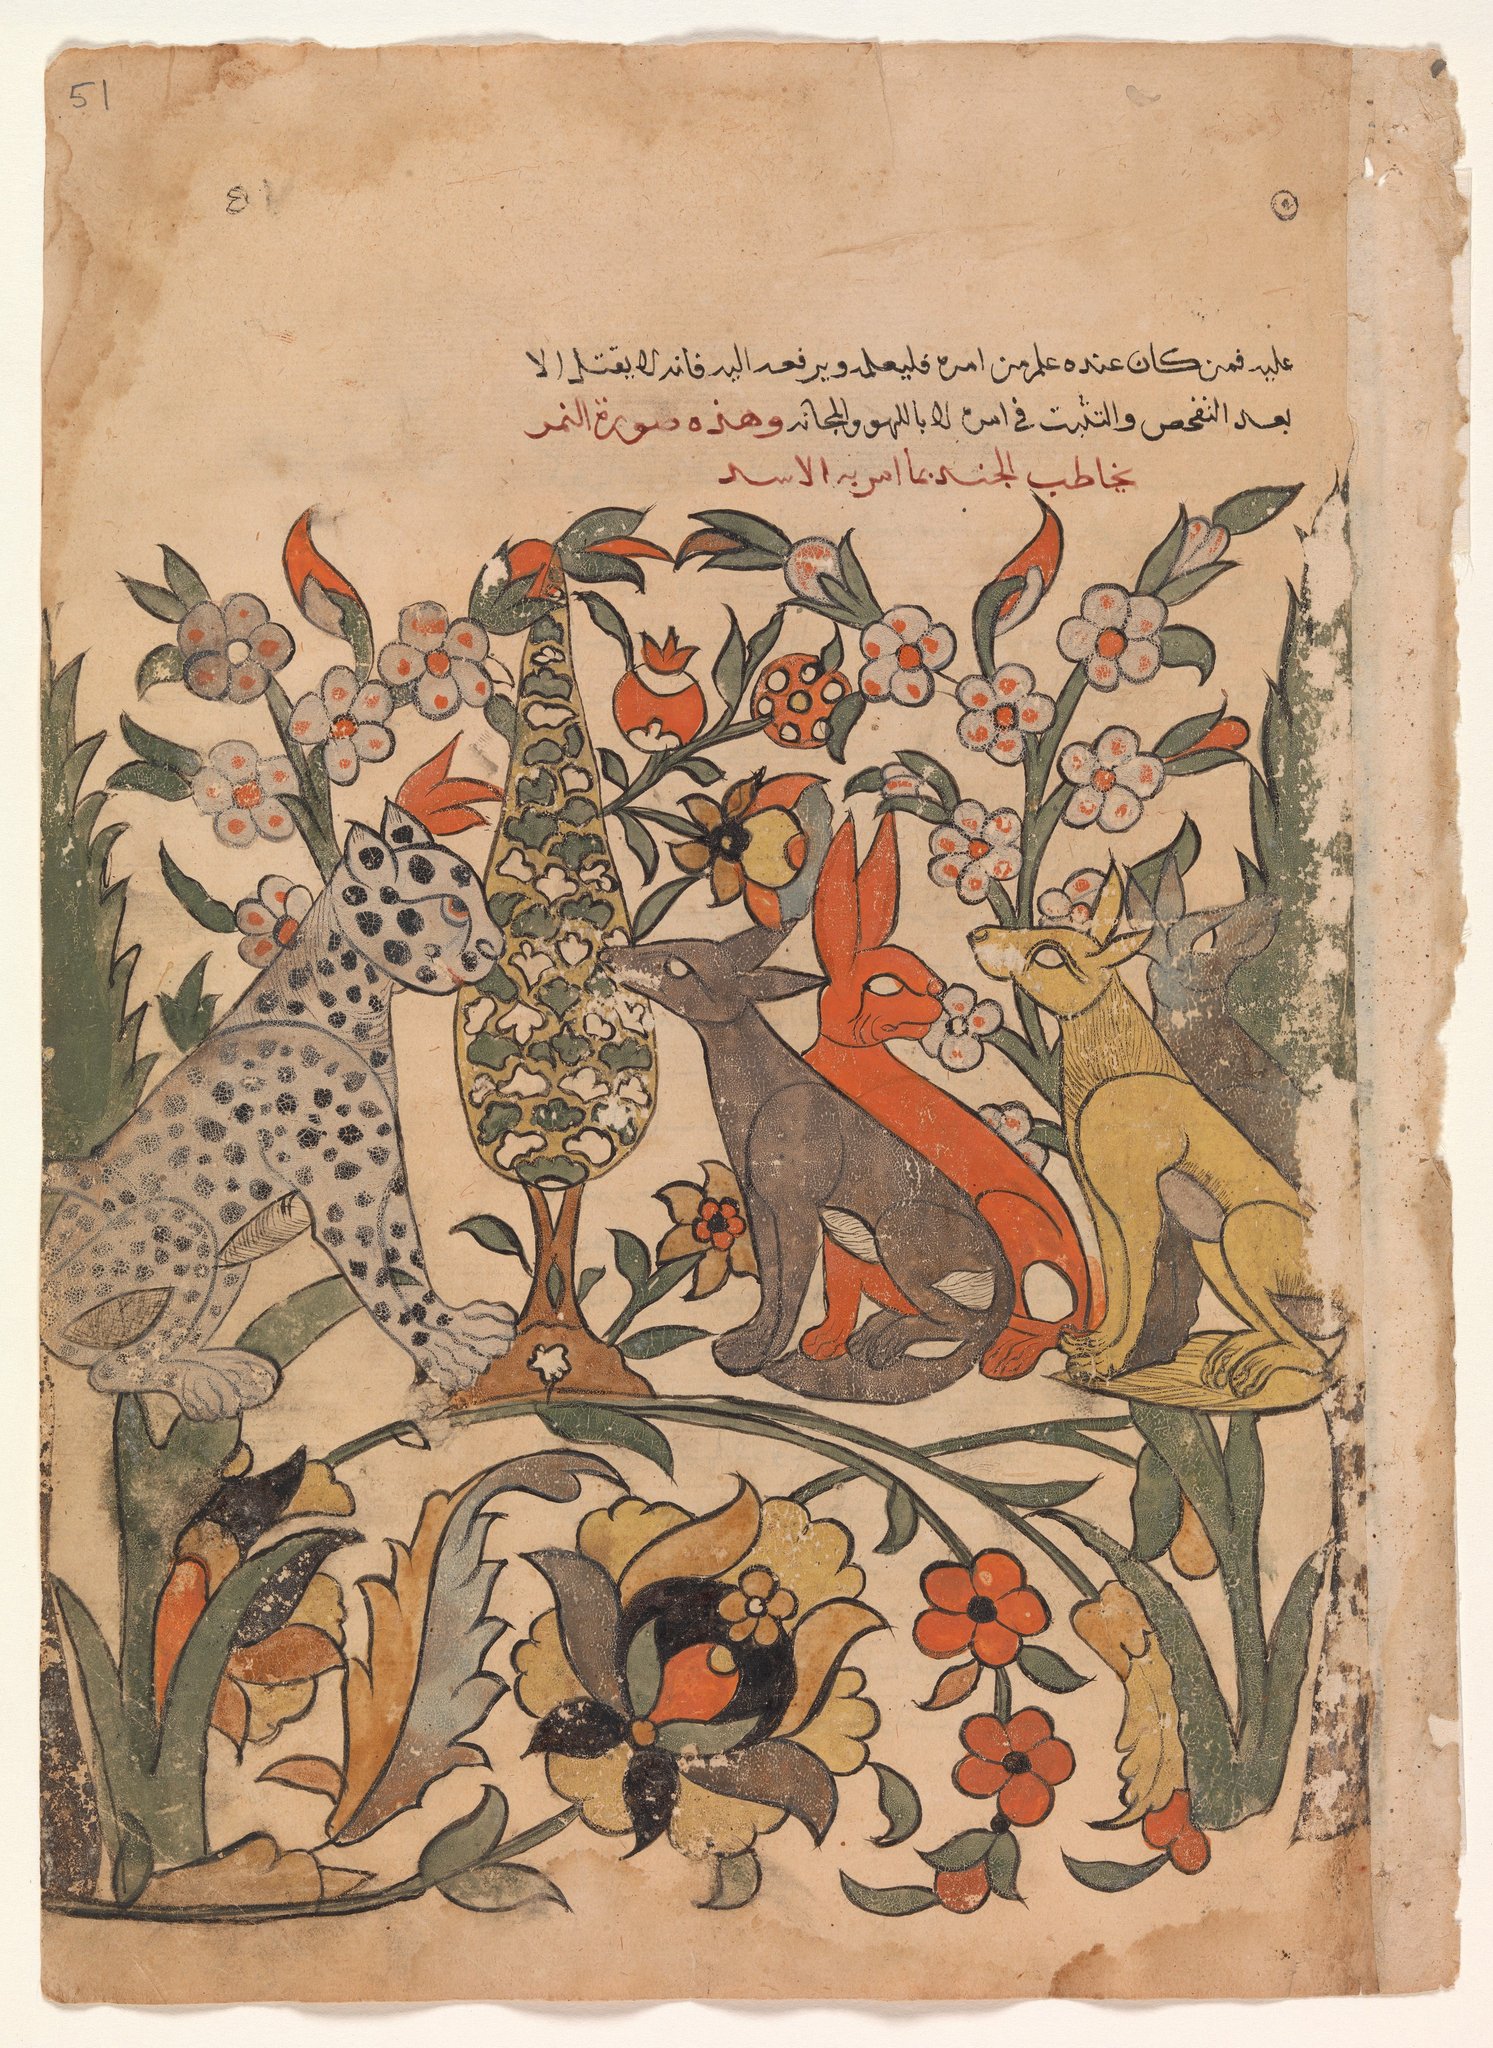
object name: folio from an illustrated manuscript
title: "Leopard Bearing Lion's Order to Fellow Judges", Folio 51 recto from a Kalila wa Dimna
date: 1526-1550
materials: ink, paper, watercolor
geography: india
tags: animals,leopards,flowers